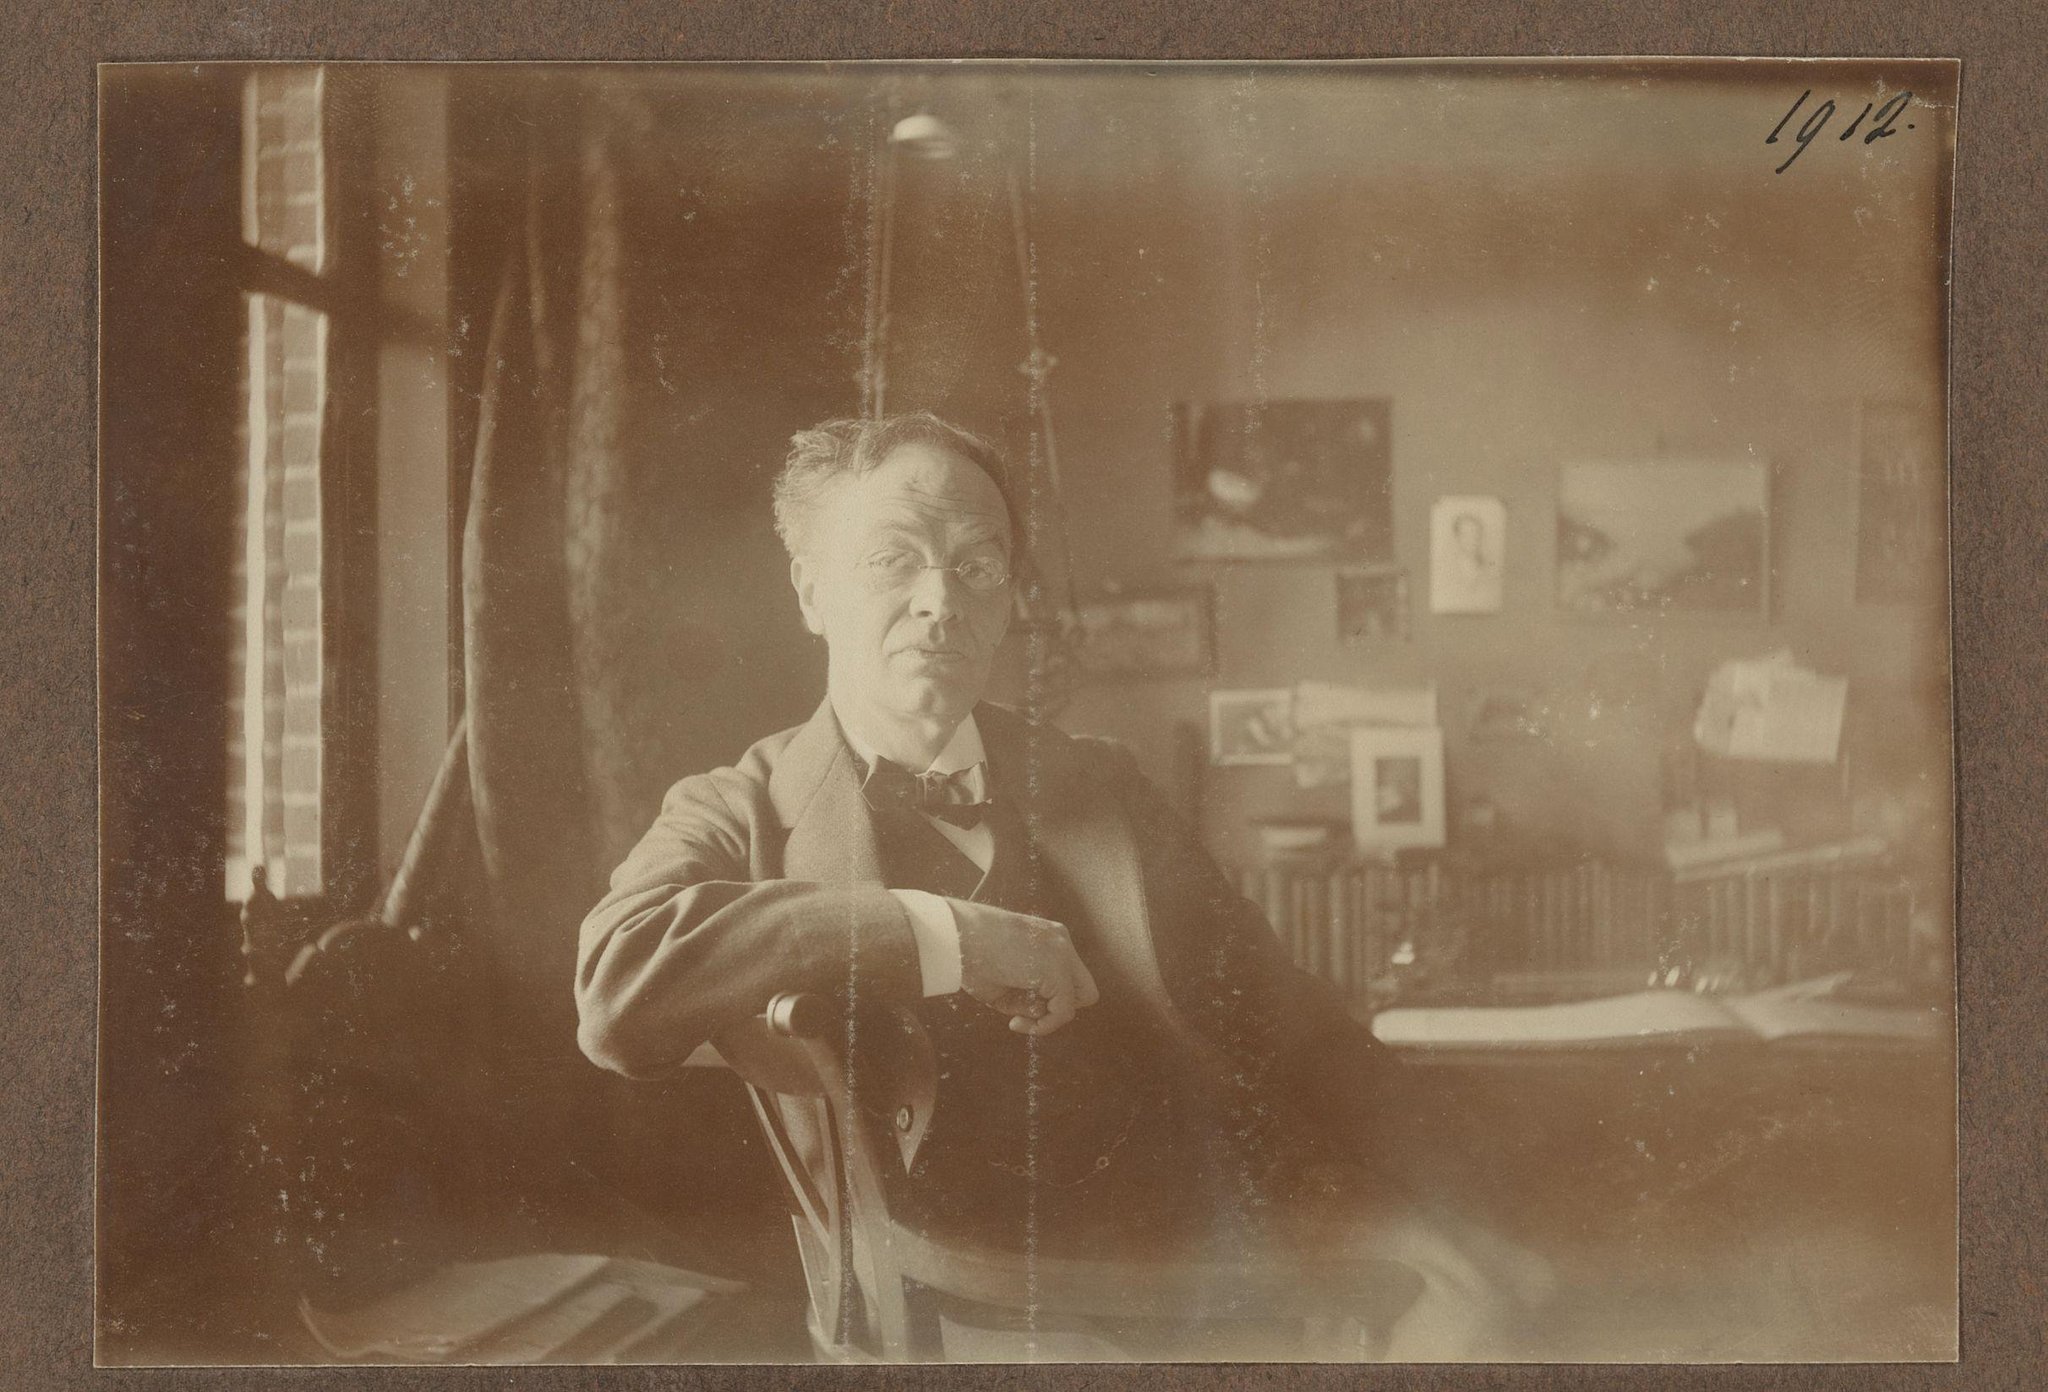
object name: photograph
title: Alphons Diepenbrock zittend in interieur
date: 1912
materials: photographic support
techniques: photography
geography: amsterdam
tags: amsterdam, alphons diepenbrock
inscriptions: date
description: Foto op bruin albumblad 6 van familiealbum van Alphons Diepenbrock.